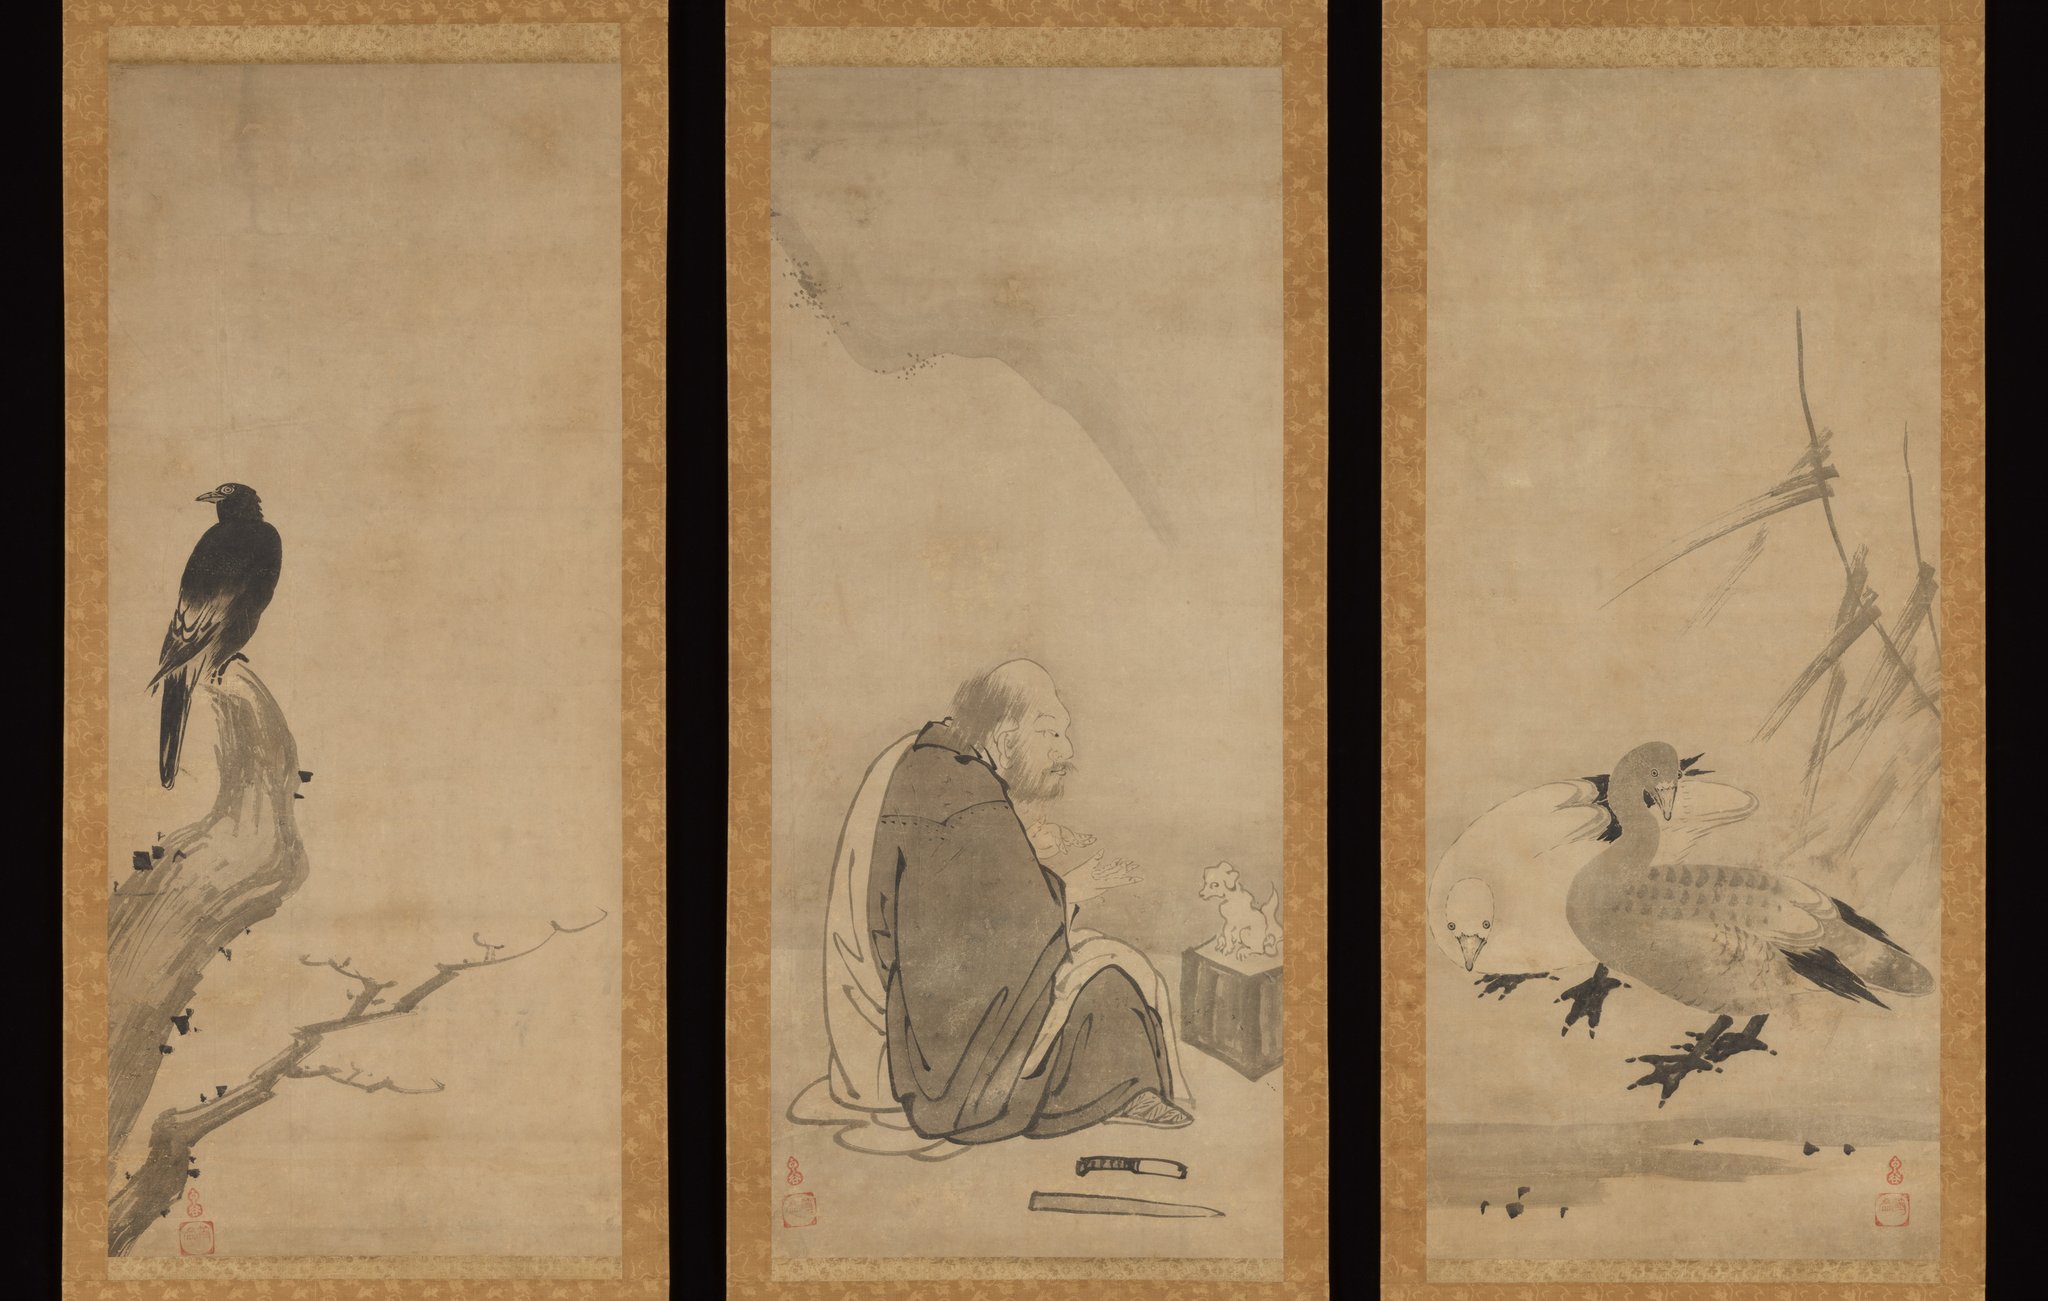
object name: hanging scroll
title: Monk Zhaozhou and Dog, with Geese and Mynah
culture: japanese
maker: unkoku tōeki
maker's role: artist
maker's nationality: japanese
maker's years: 1591-1644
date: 1601-1650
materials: ink, paper